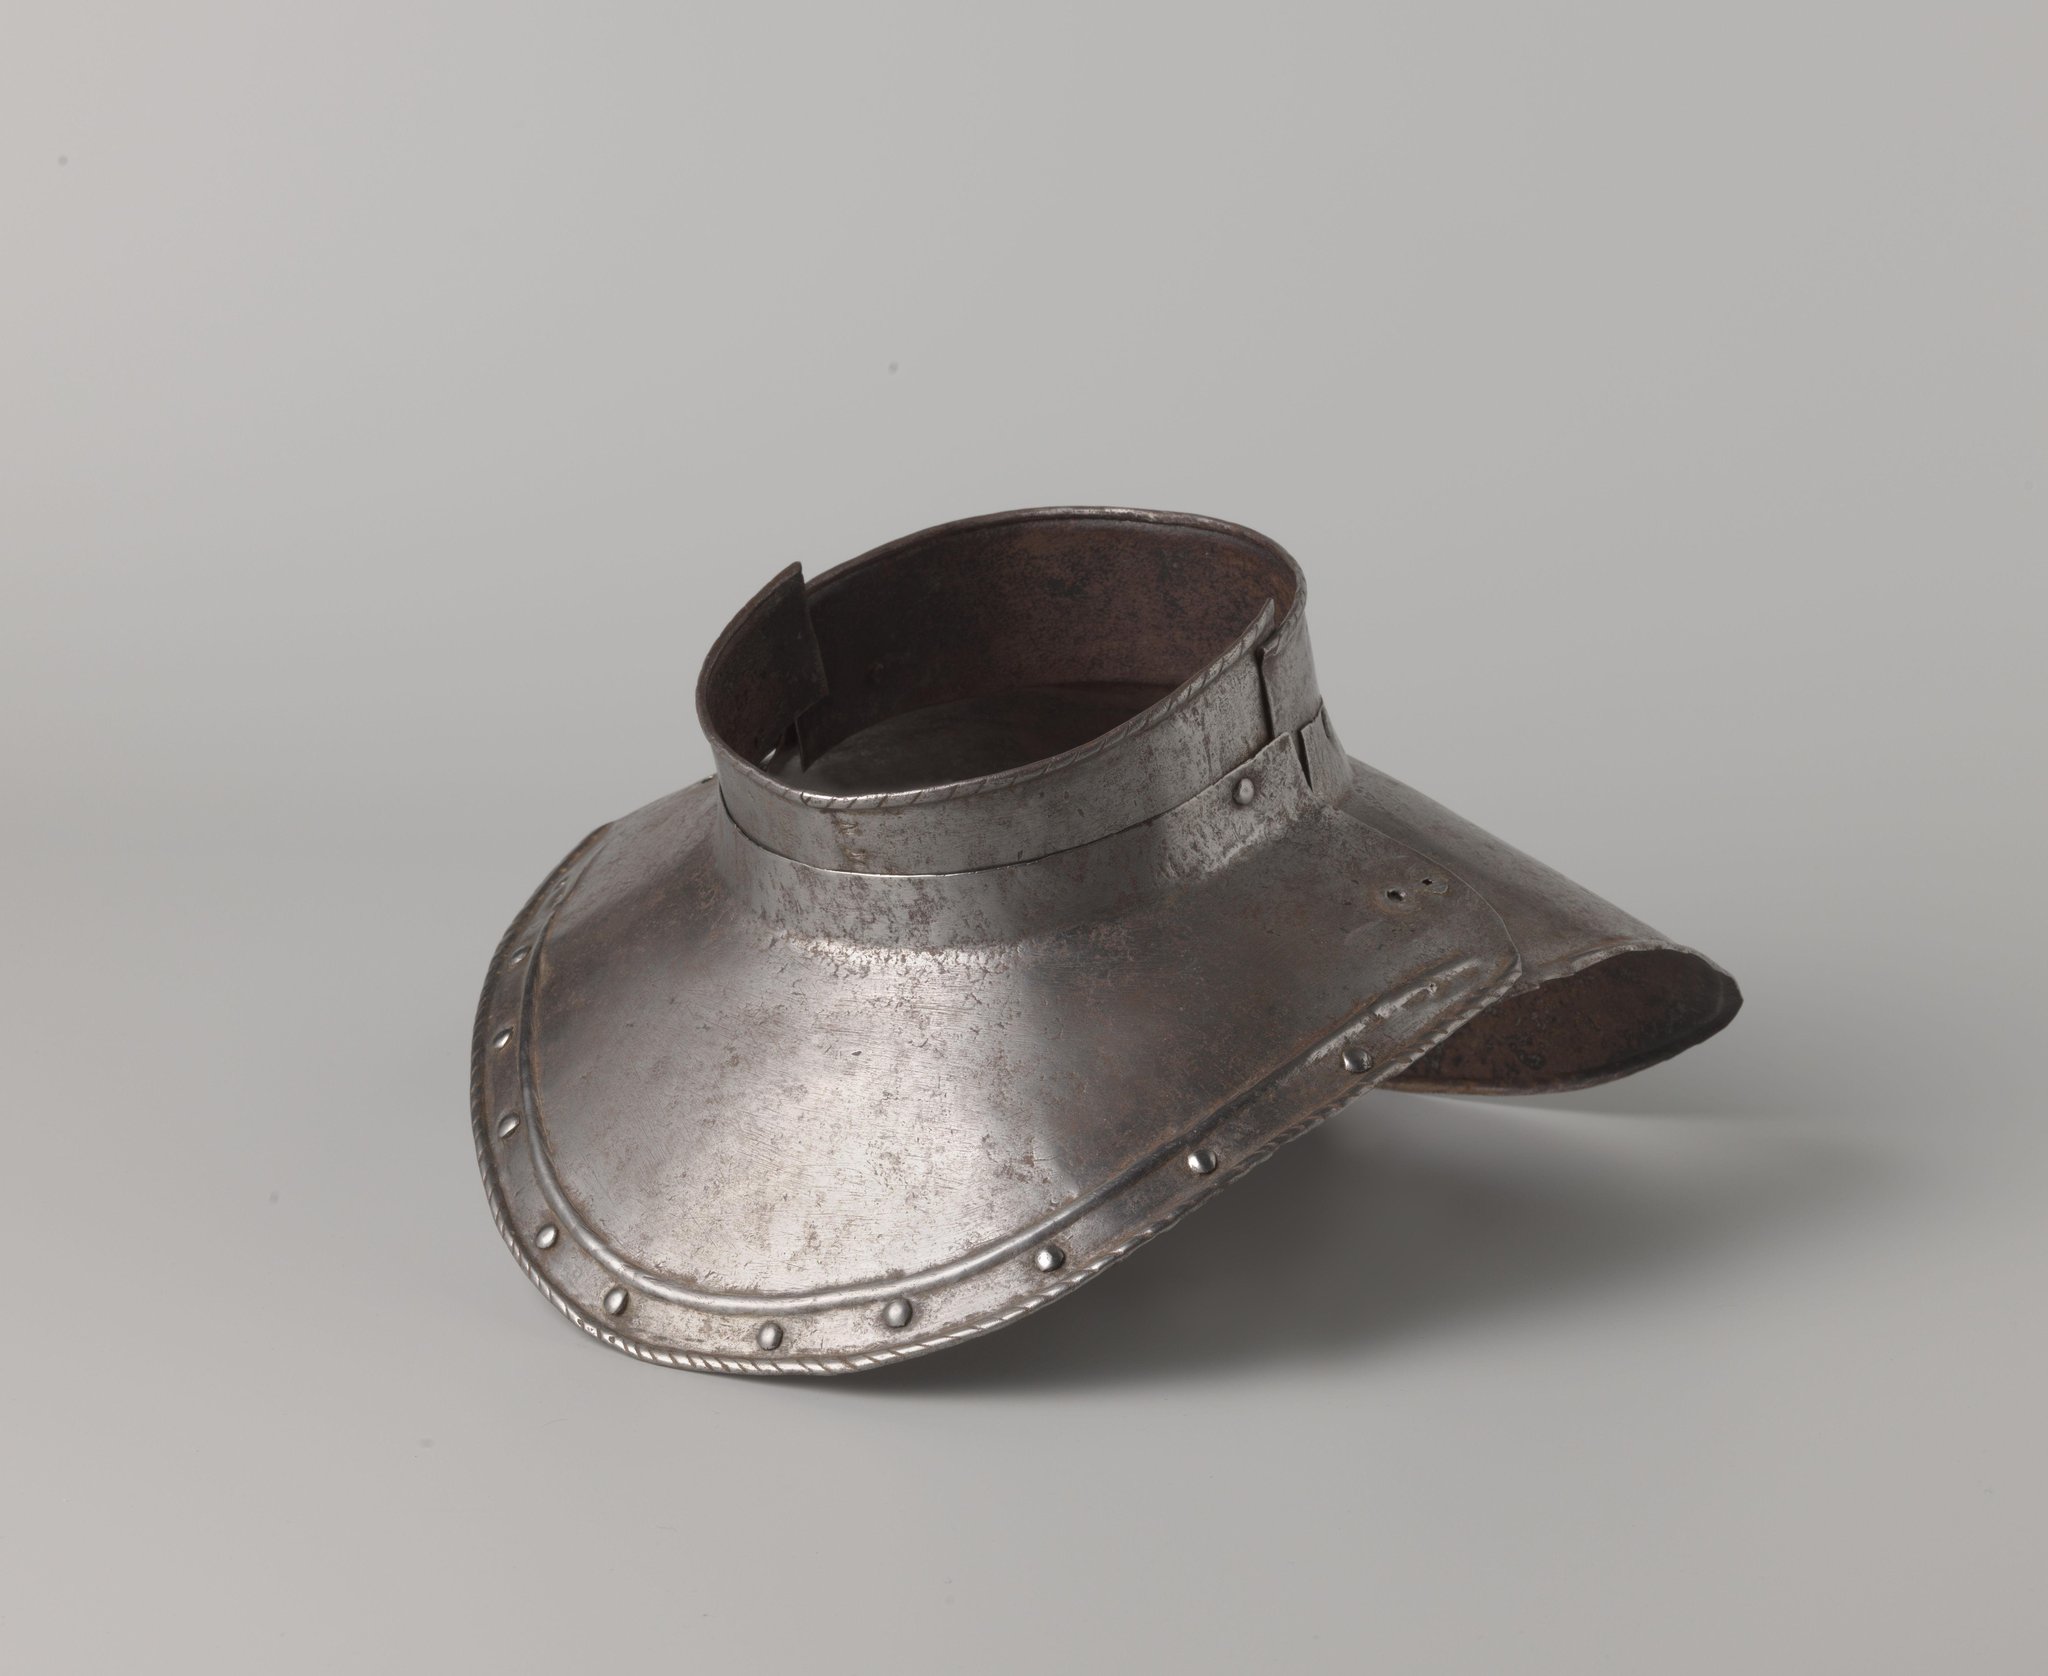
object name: gorget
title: Ringkraag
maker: Anonymous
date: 1499-1699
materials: iron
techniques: engraving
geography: europe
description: Ringkraag, ijzer, blank, uit vier delen gemaakt die aan weerzijden van de opening aan elkaar zijn geklonken met ronde opening in het midden. De randen zijn omhoog geflenst en zijn gekabeld. Aan de voorzijde een iets omhoog gebolde rand met daartussen ijzeren klinknagels. Opening voor het hoofd heeft een omgeflenste rand die gekabeld is, bestaat uit twee delen die aan weerzijden van binnen aan elkaar zijn geklonken. De binnenzijde is zwart geverfd.